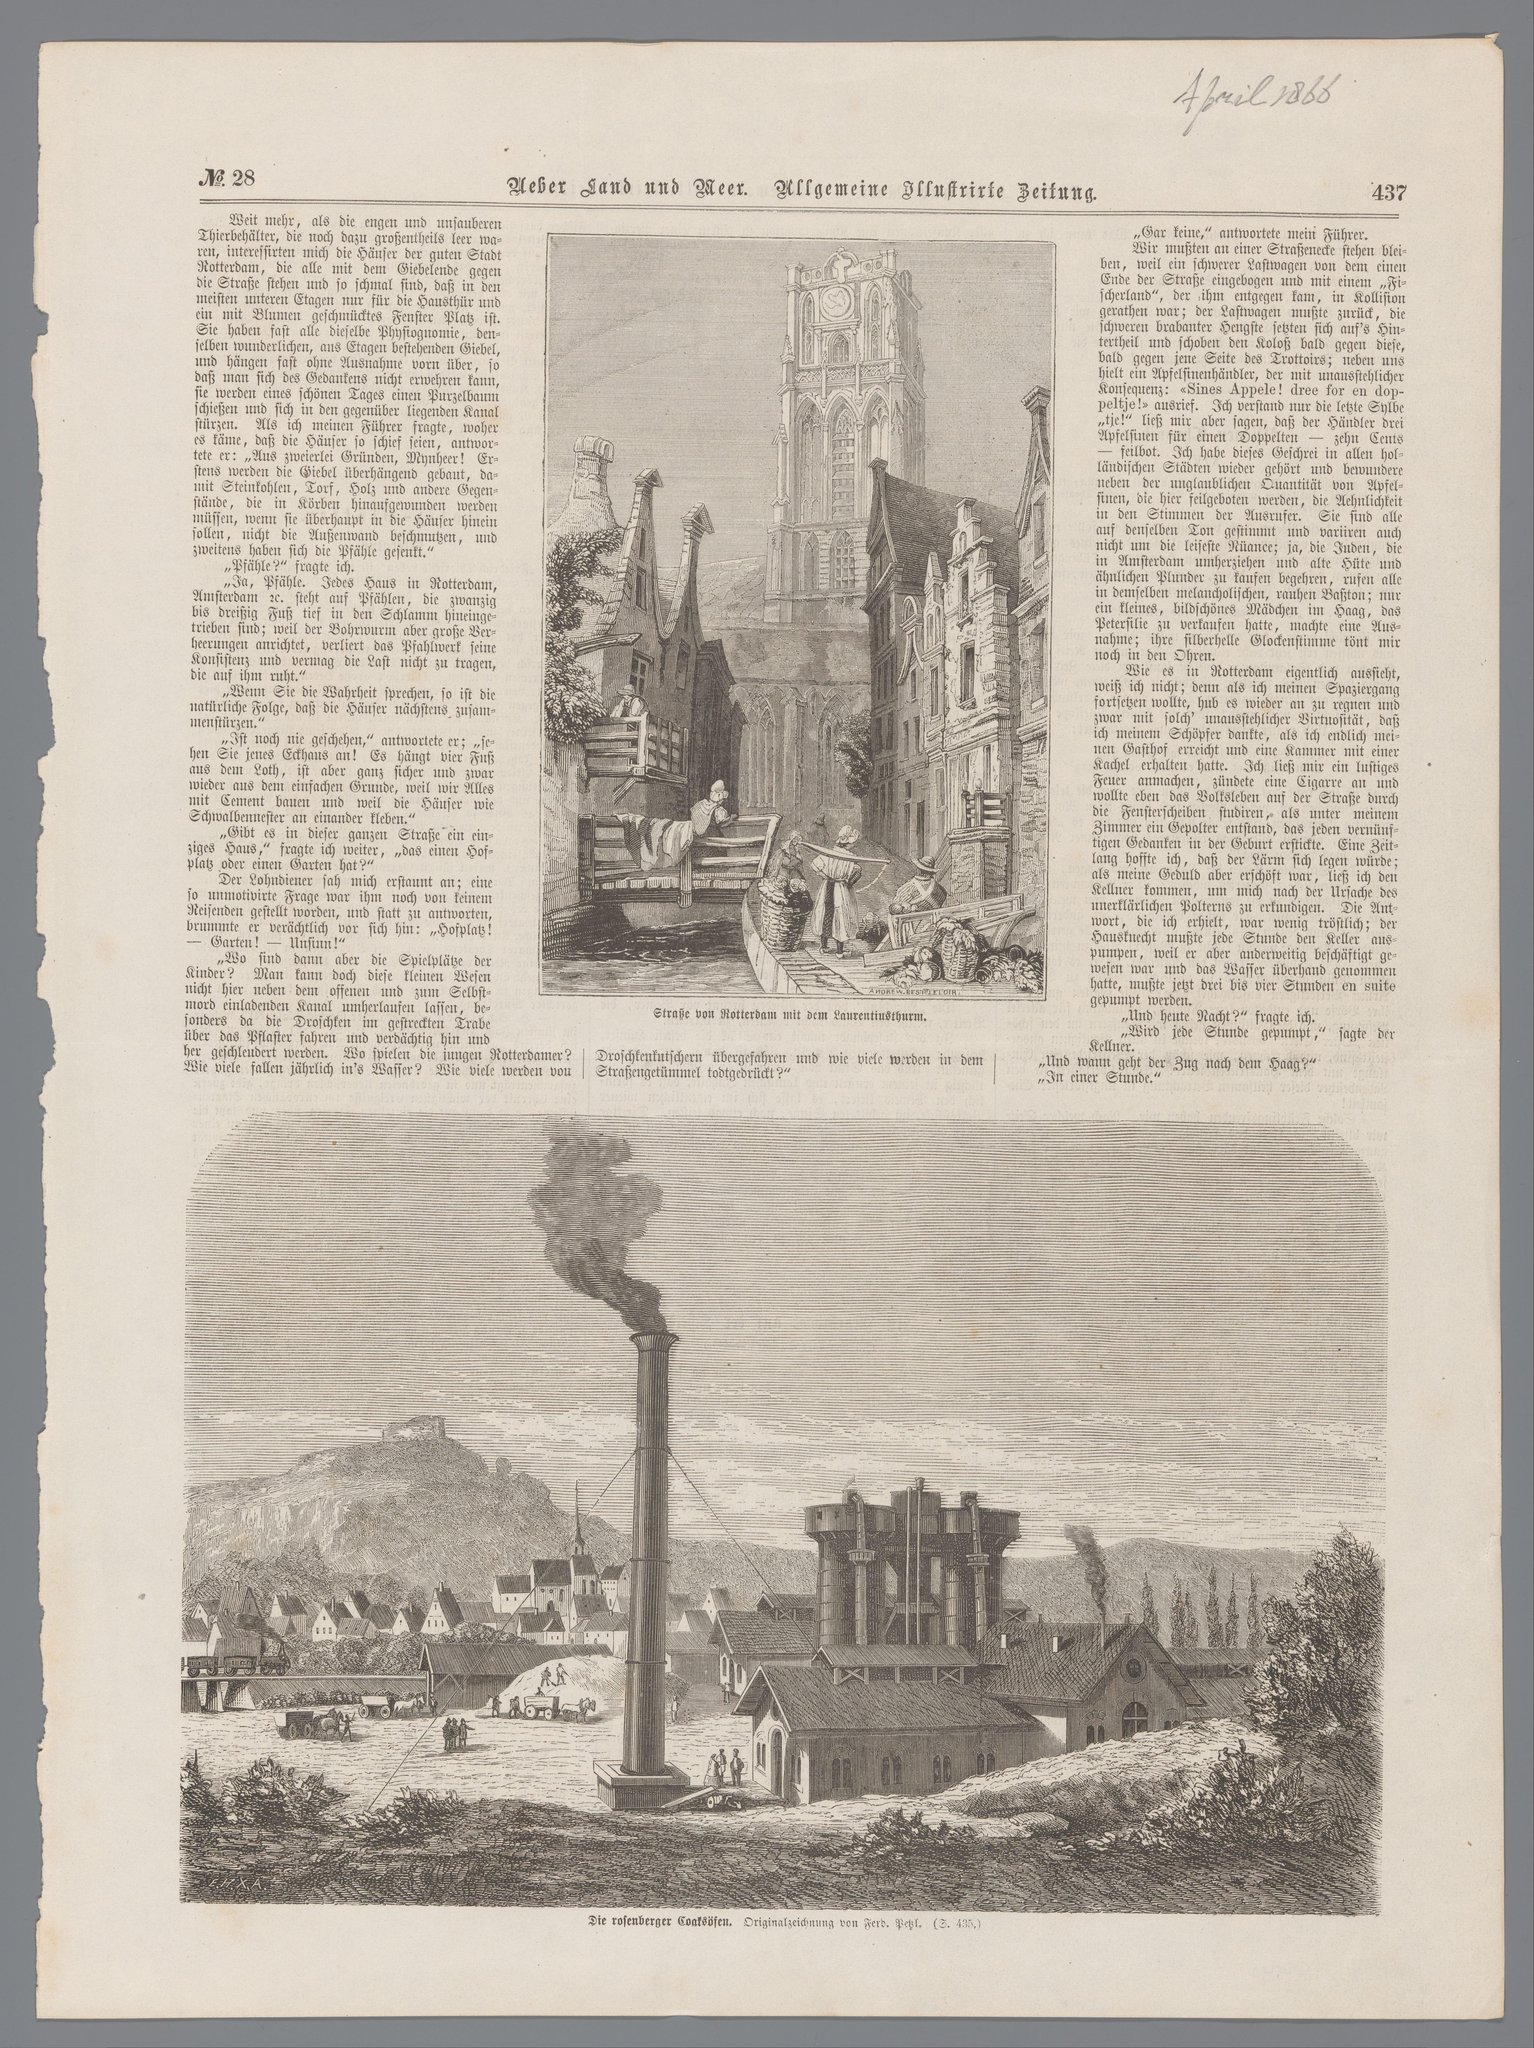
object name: print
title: Die rosenberger Coaksöfen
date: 1866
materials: paper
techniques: letterpress printing, engraving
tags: burning as process: coal, smelting, extracting from ore; blast-furnace, church (exterior)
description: Blad uit: Hackländer, F.W. (red.). Über Land und Meer. Stuttgart: Eduard Hallberger, 1858-1924, dl. 16 (april-september 1866), nr. 28, p. 437.